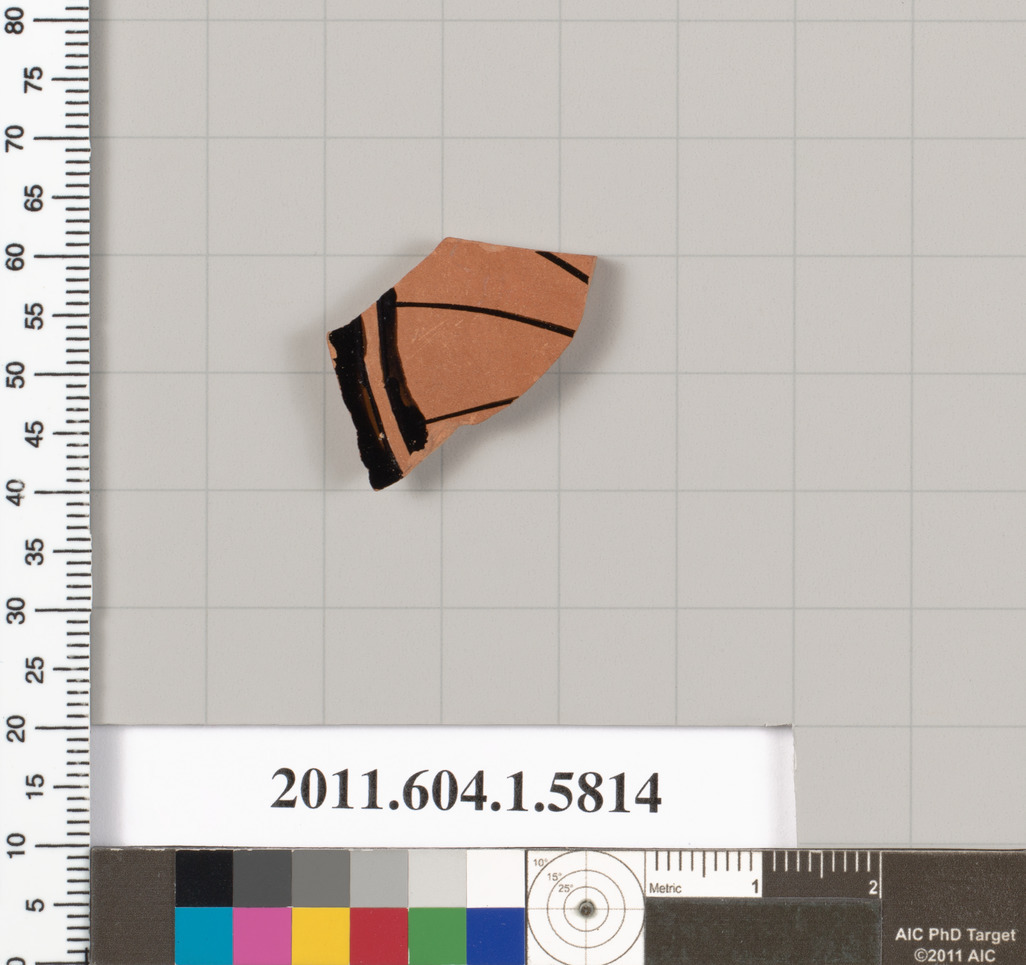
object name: kylix fragment, eye cup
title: Terracotta fragment of a kylix: eye-cup (drinking cup)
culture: greek, attic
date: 520-510 BCE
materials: terracotta